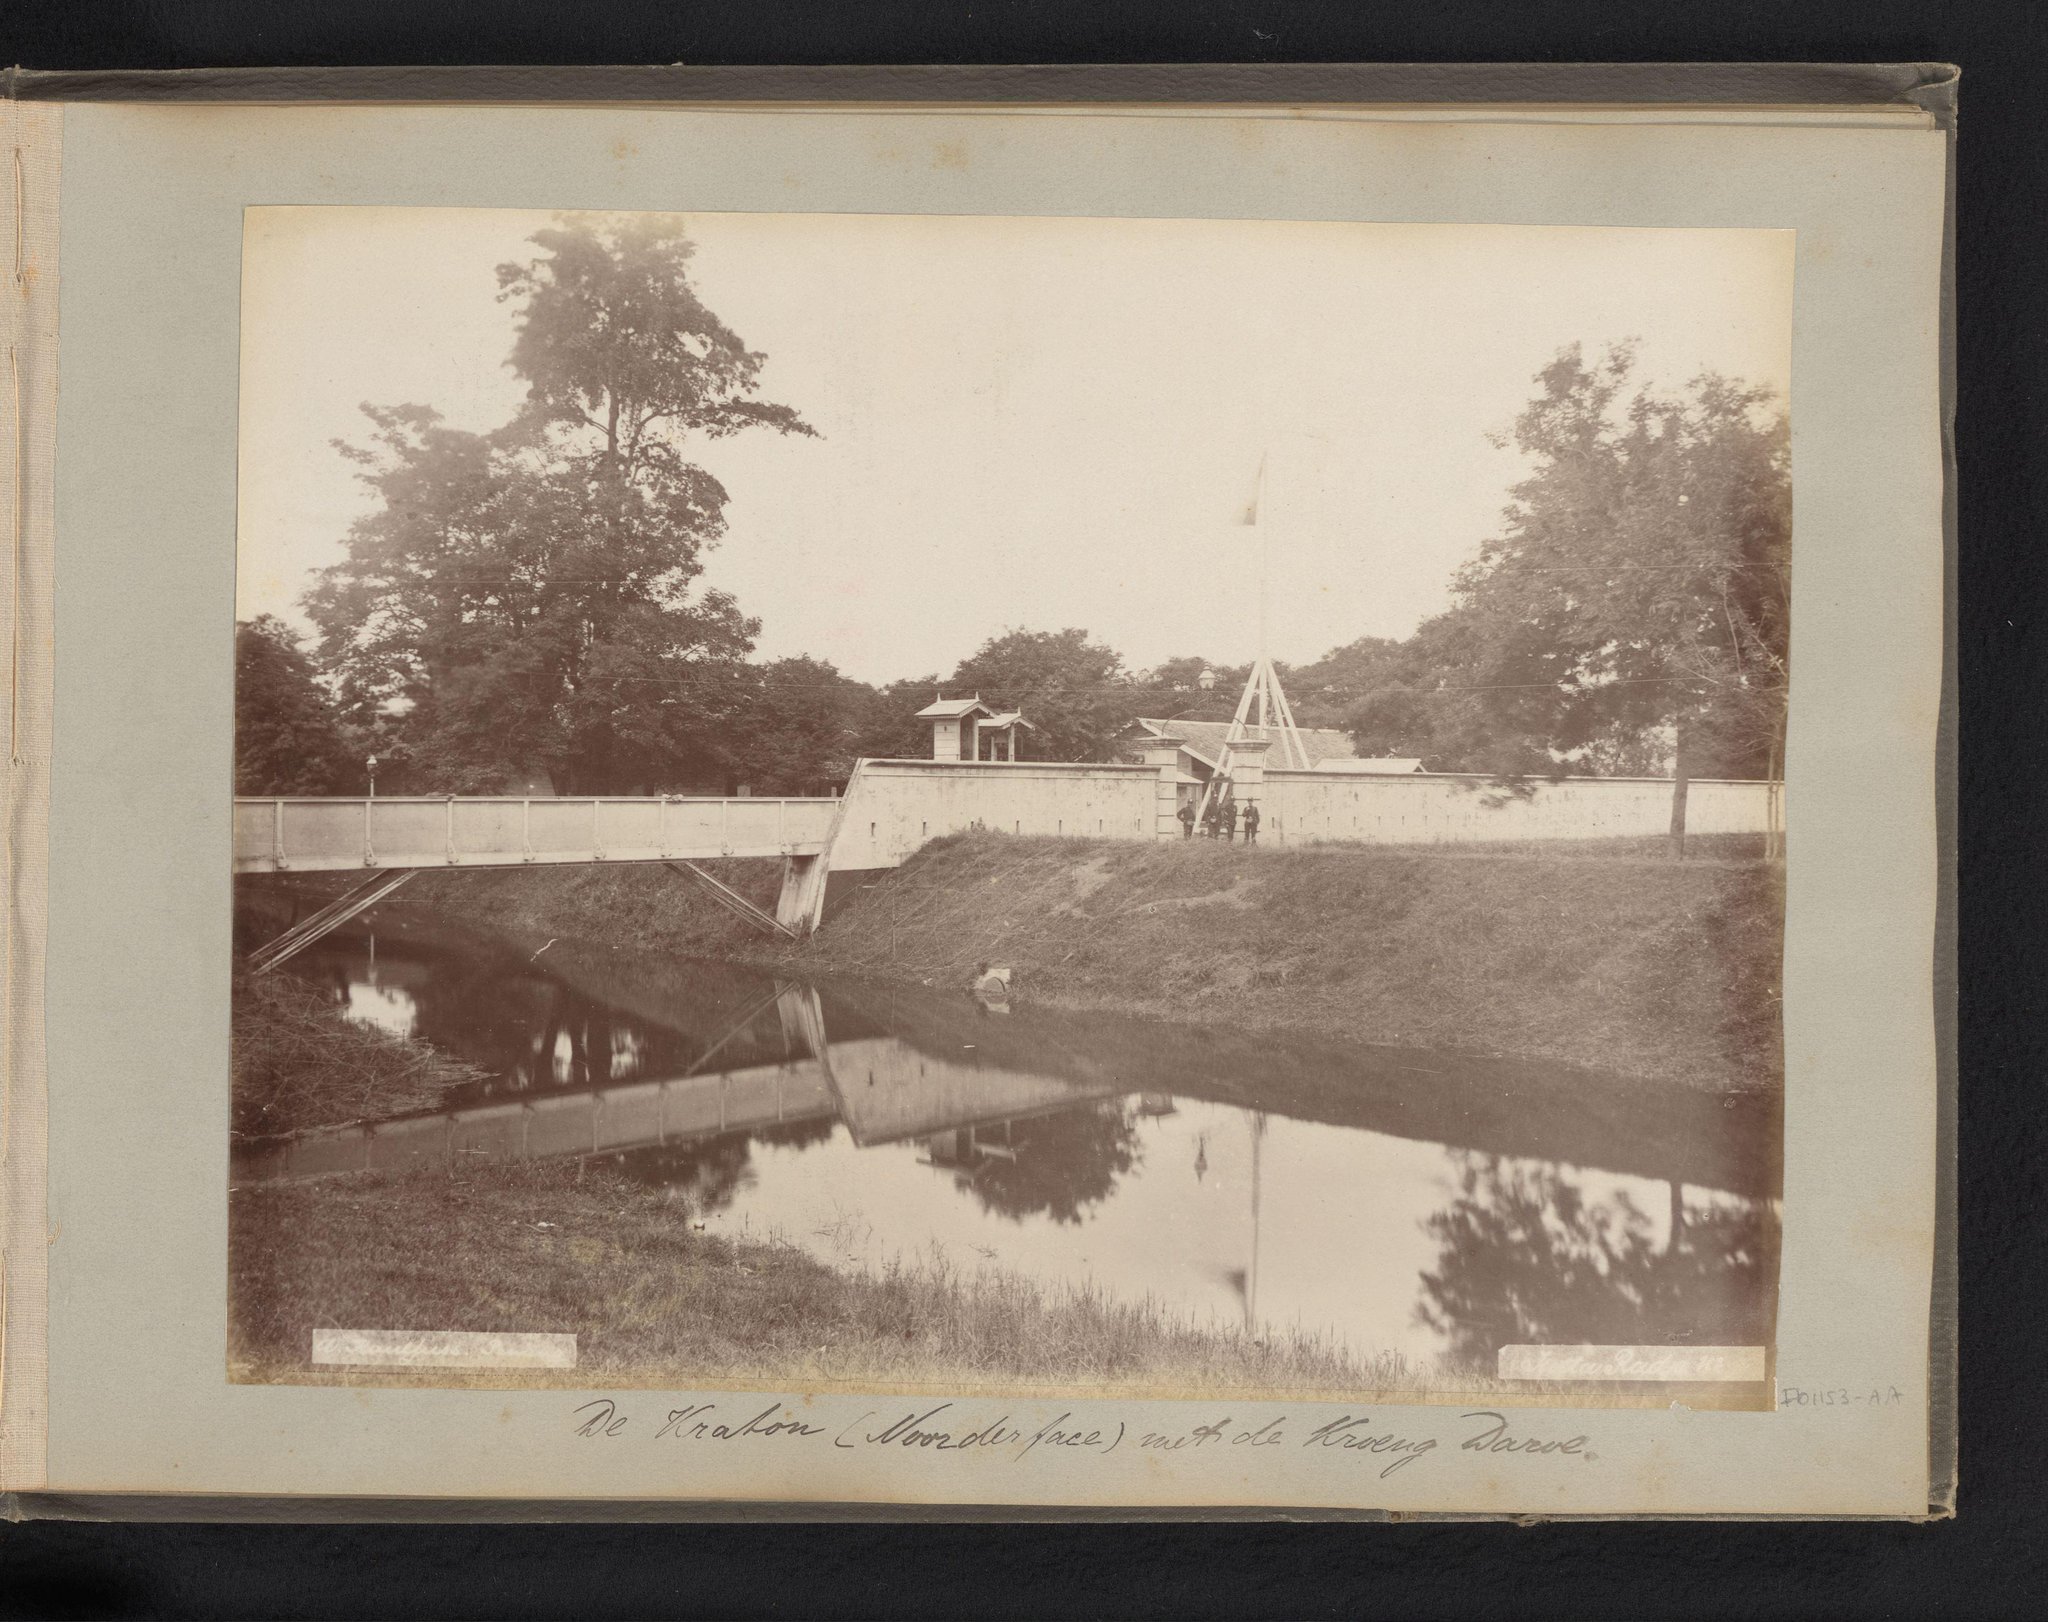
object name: photograph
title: Brug over de Kroeng Daroe bij een militaire post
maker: a. kaulfuss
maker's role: fotograaf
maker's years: 1861-1909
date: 1891-1894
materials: photographic support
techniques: albumen print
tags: bridge, shelter ~ military service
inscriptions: inscription: ‘A. Kaulfuss/ Kotta Radja No.’